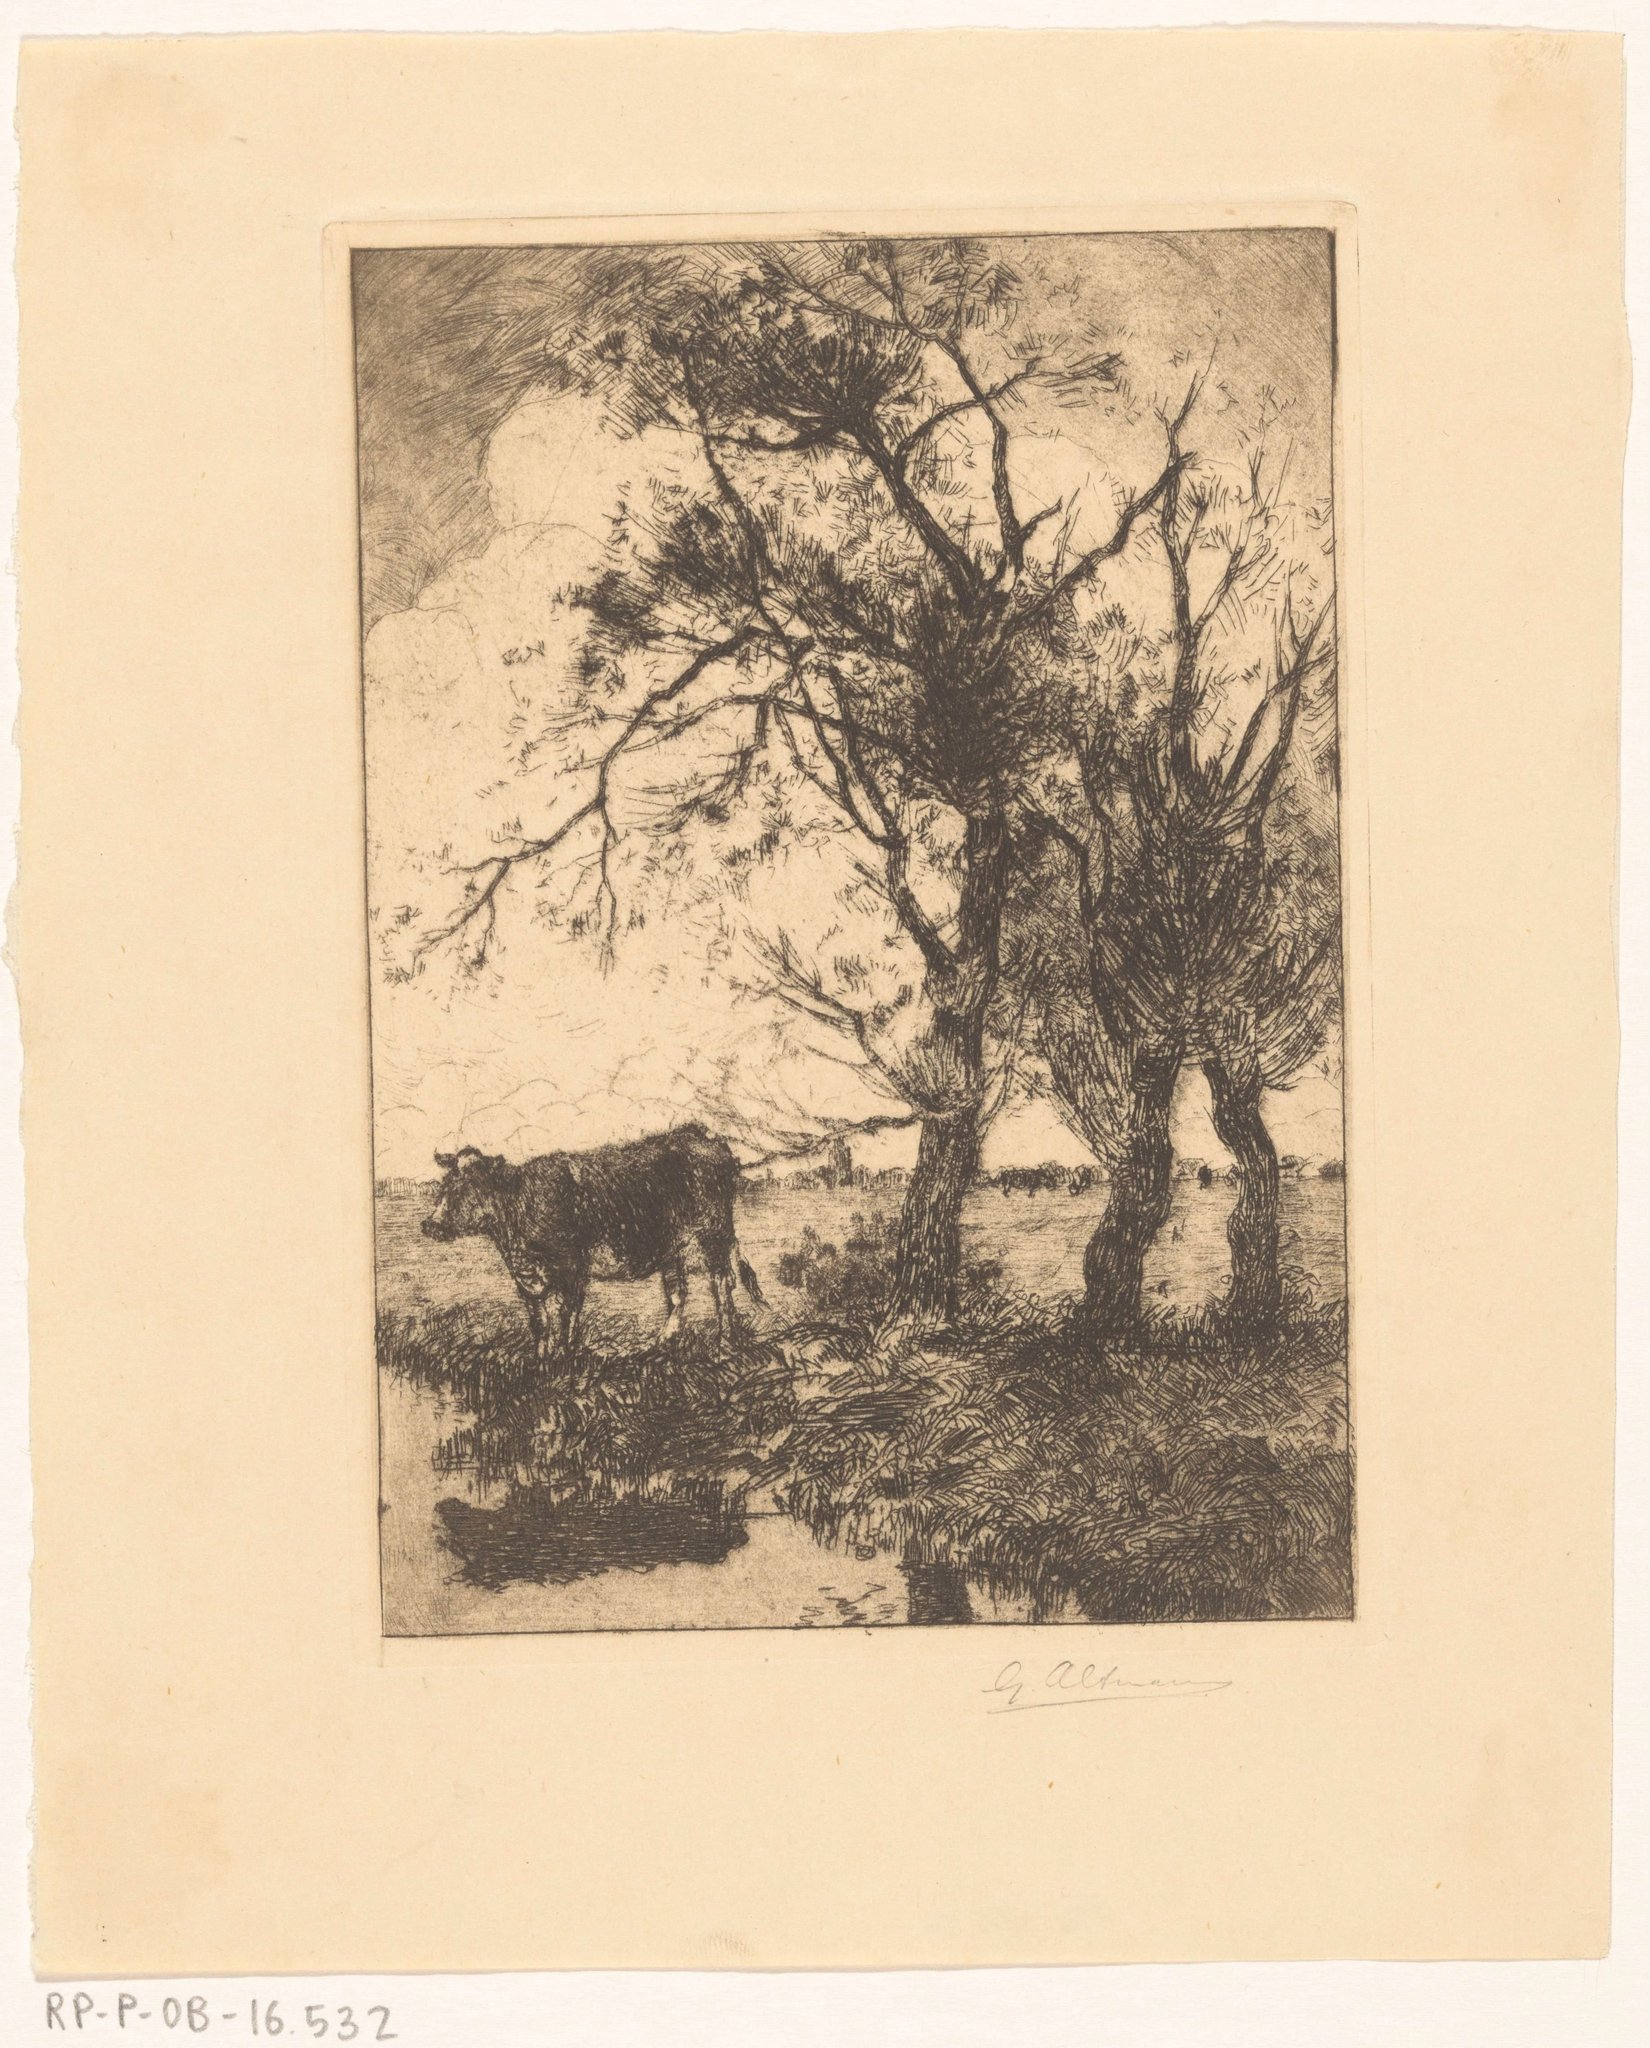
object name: print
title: Koe aan de waterkant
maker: gerard altmann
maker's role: print maker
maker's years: 1877-1940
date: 1887-1940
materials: paper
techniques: etching, intaglio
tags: cow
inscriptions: signature: ‘G. Altmann’, collector's mark: Lugt 2228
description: Staande koe aan de waterkant, naast drie bomen.